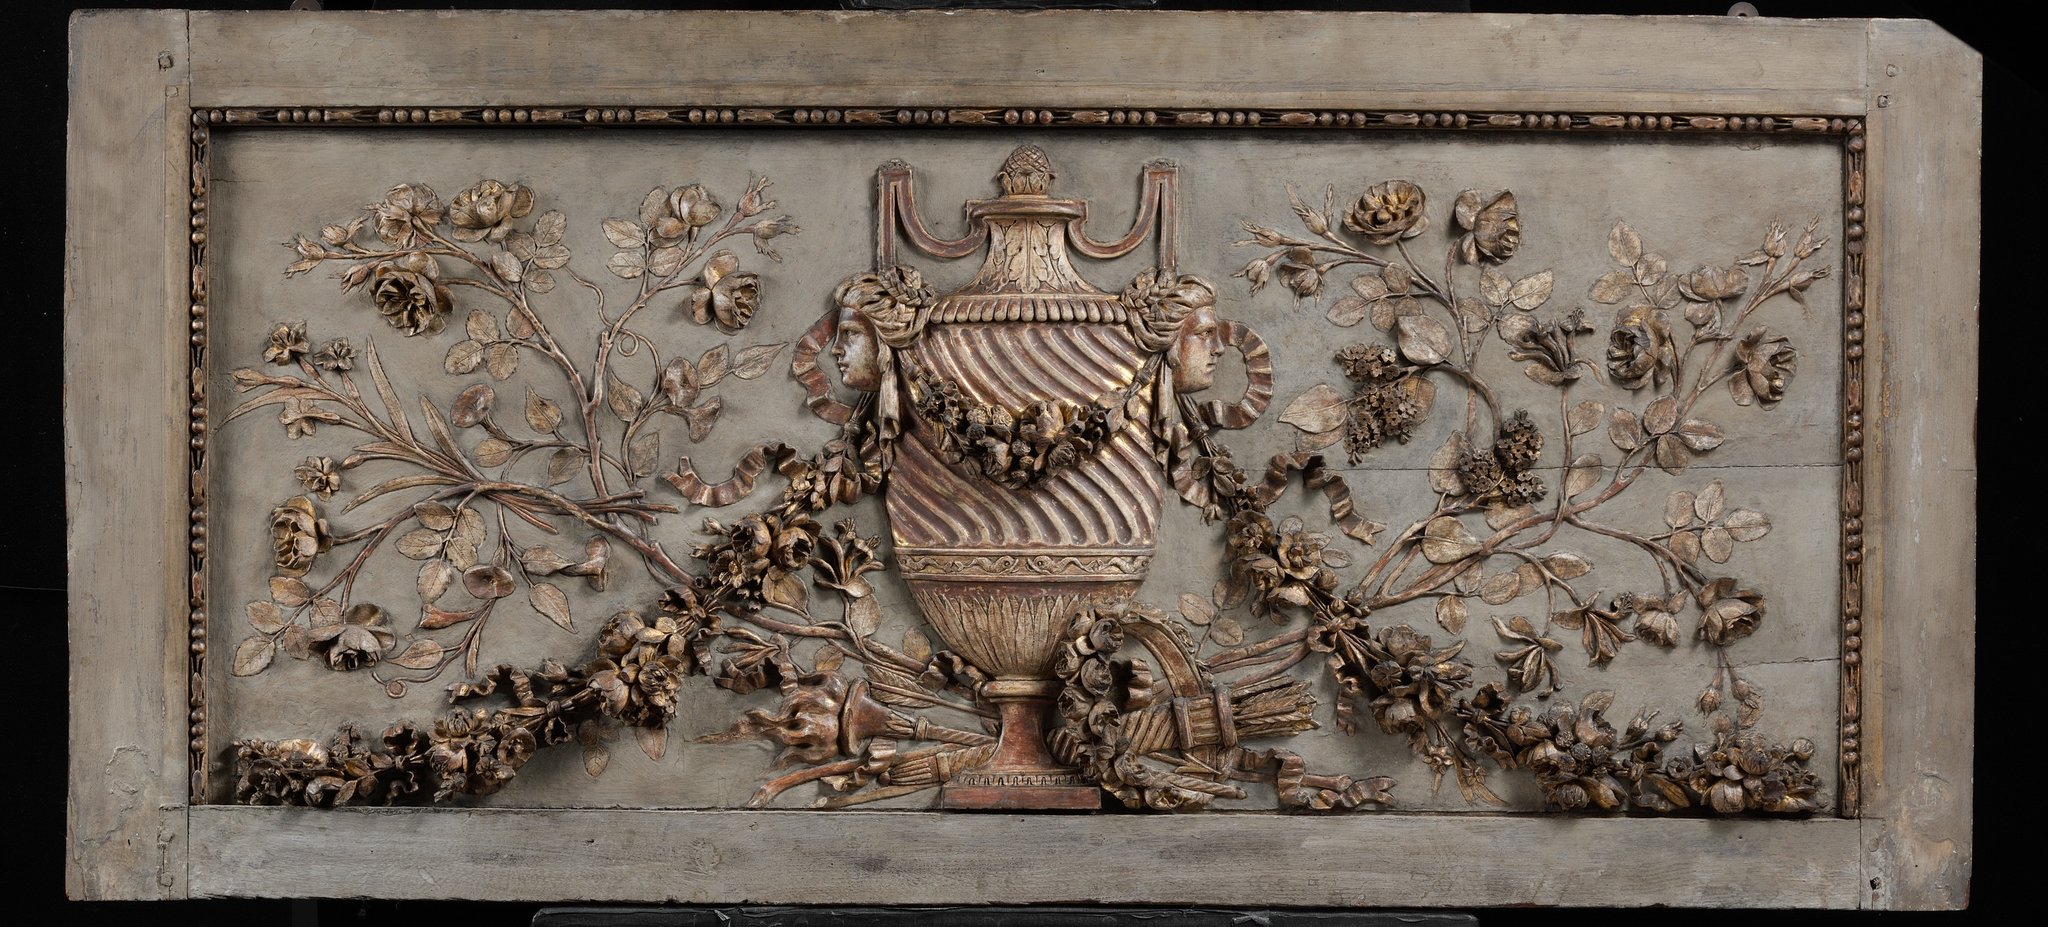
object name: panel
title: Spring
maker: françois joseph belanger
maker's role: maker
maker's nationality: french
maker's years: 1744-1818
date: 1775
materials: gilt, wood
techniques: carving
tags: faces,flowers,plants